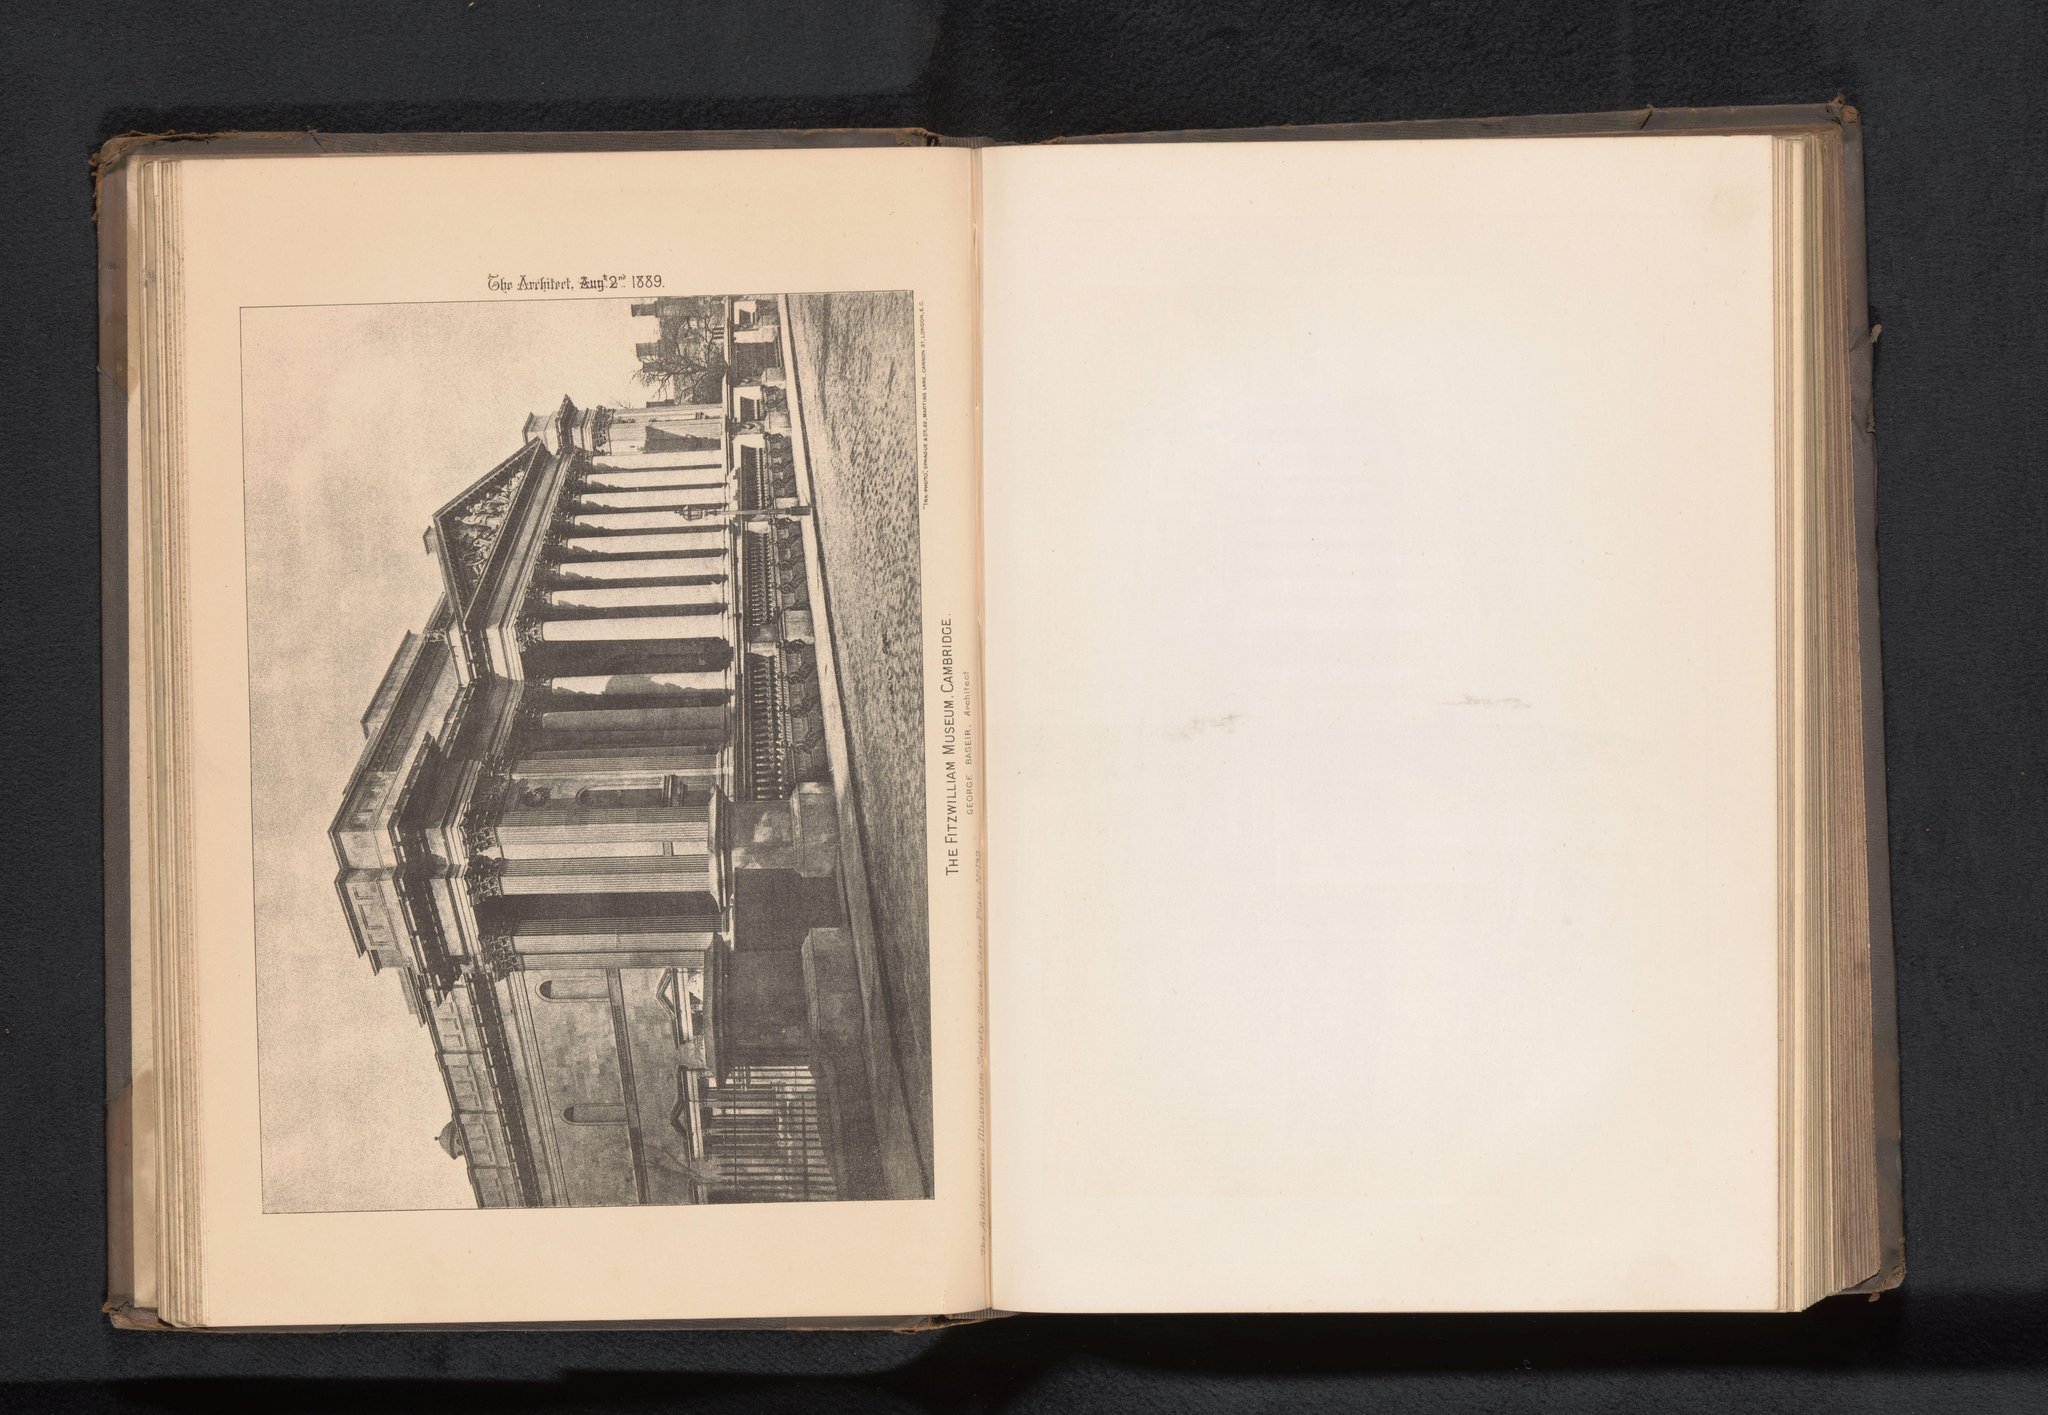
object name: photomechanical print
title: Gezicht op het Fitzwilliam Museum te Cambridge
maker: Anonymous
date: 1884-1889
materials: paper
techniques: photolithography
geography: cambridge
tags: permanent exhibition, museum, façade (of house or building)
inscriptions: inscription: ‘George Baseir, Architect/ The Architectural Illustration Society. Second Series Plate No.132’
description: Prent op vierde ongenummerde pagina na pagina 64.